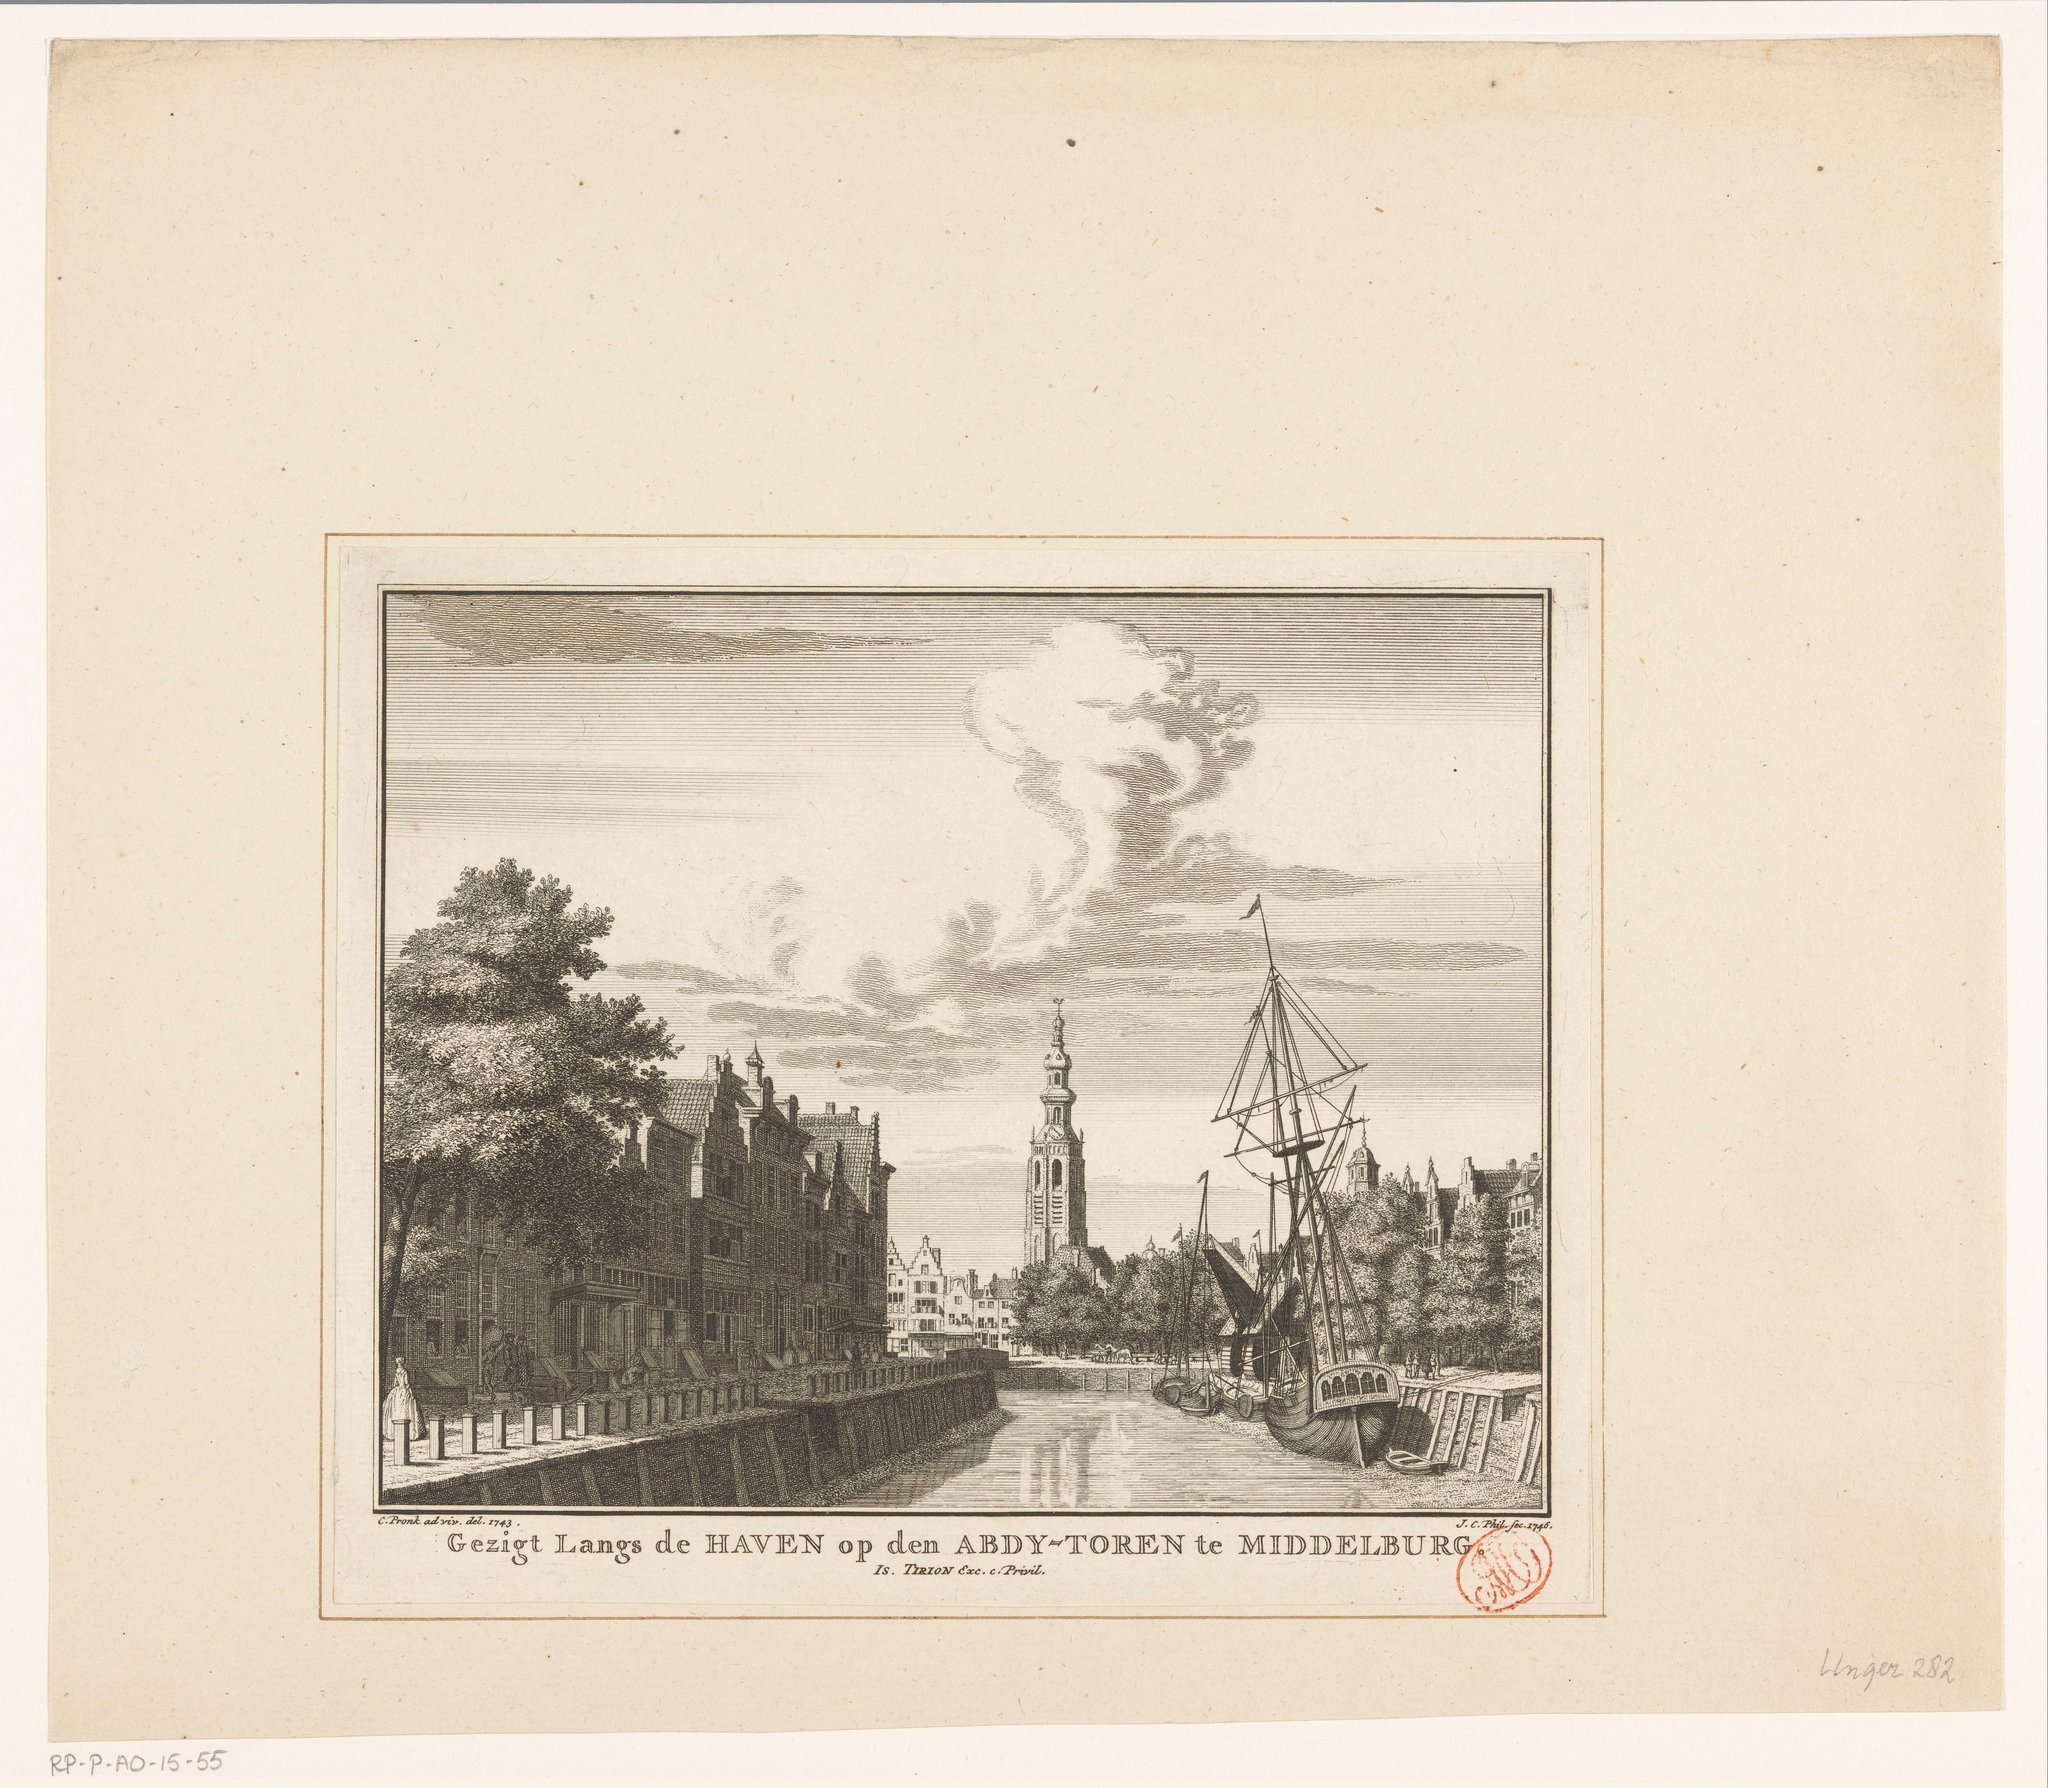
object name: print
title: Gezicht op de Lange Jan (Abdijtoren) te Middelburg, 1743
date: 1746-1760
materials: paper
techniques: etching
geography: amsterdam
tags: harbour, church (exterior), prospect of city, town panorama, silhouette of city, middelburg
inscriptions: collector's mark: Lugt 195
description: Gezicht op de Lange Jan, ook wel bekend als de Abdijtoren, te Middelburg. Op de voorgrond een deel van de haven. In de situatie omstreeks 1743.